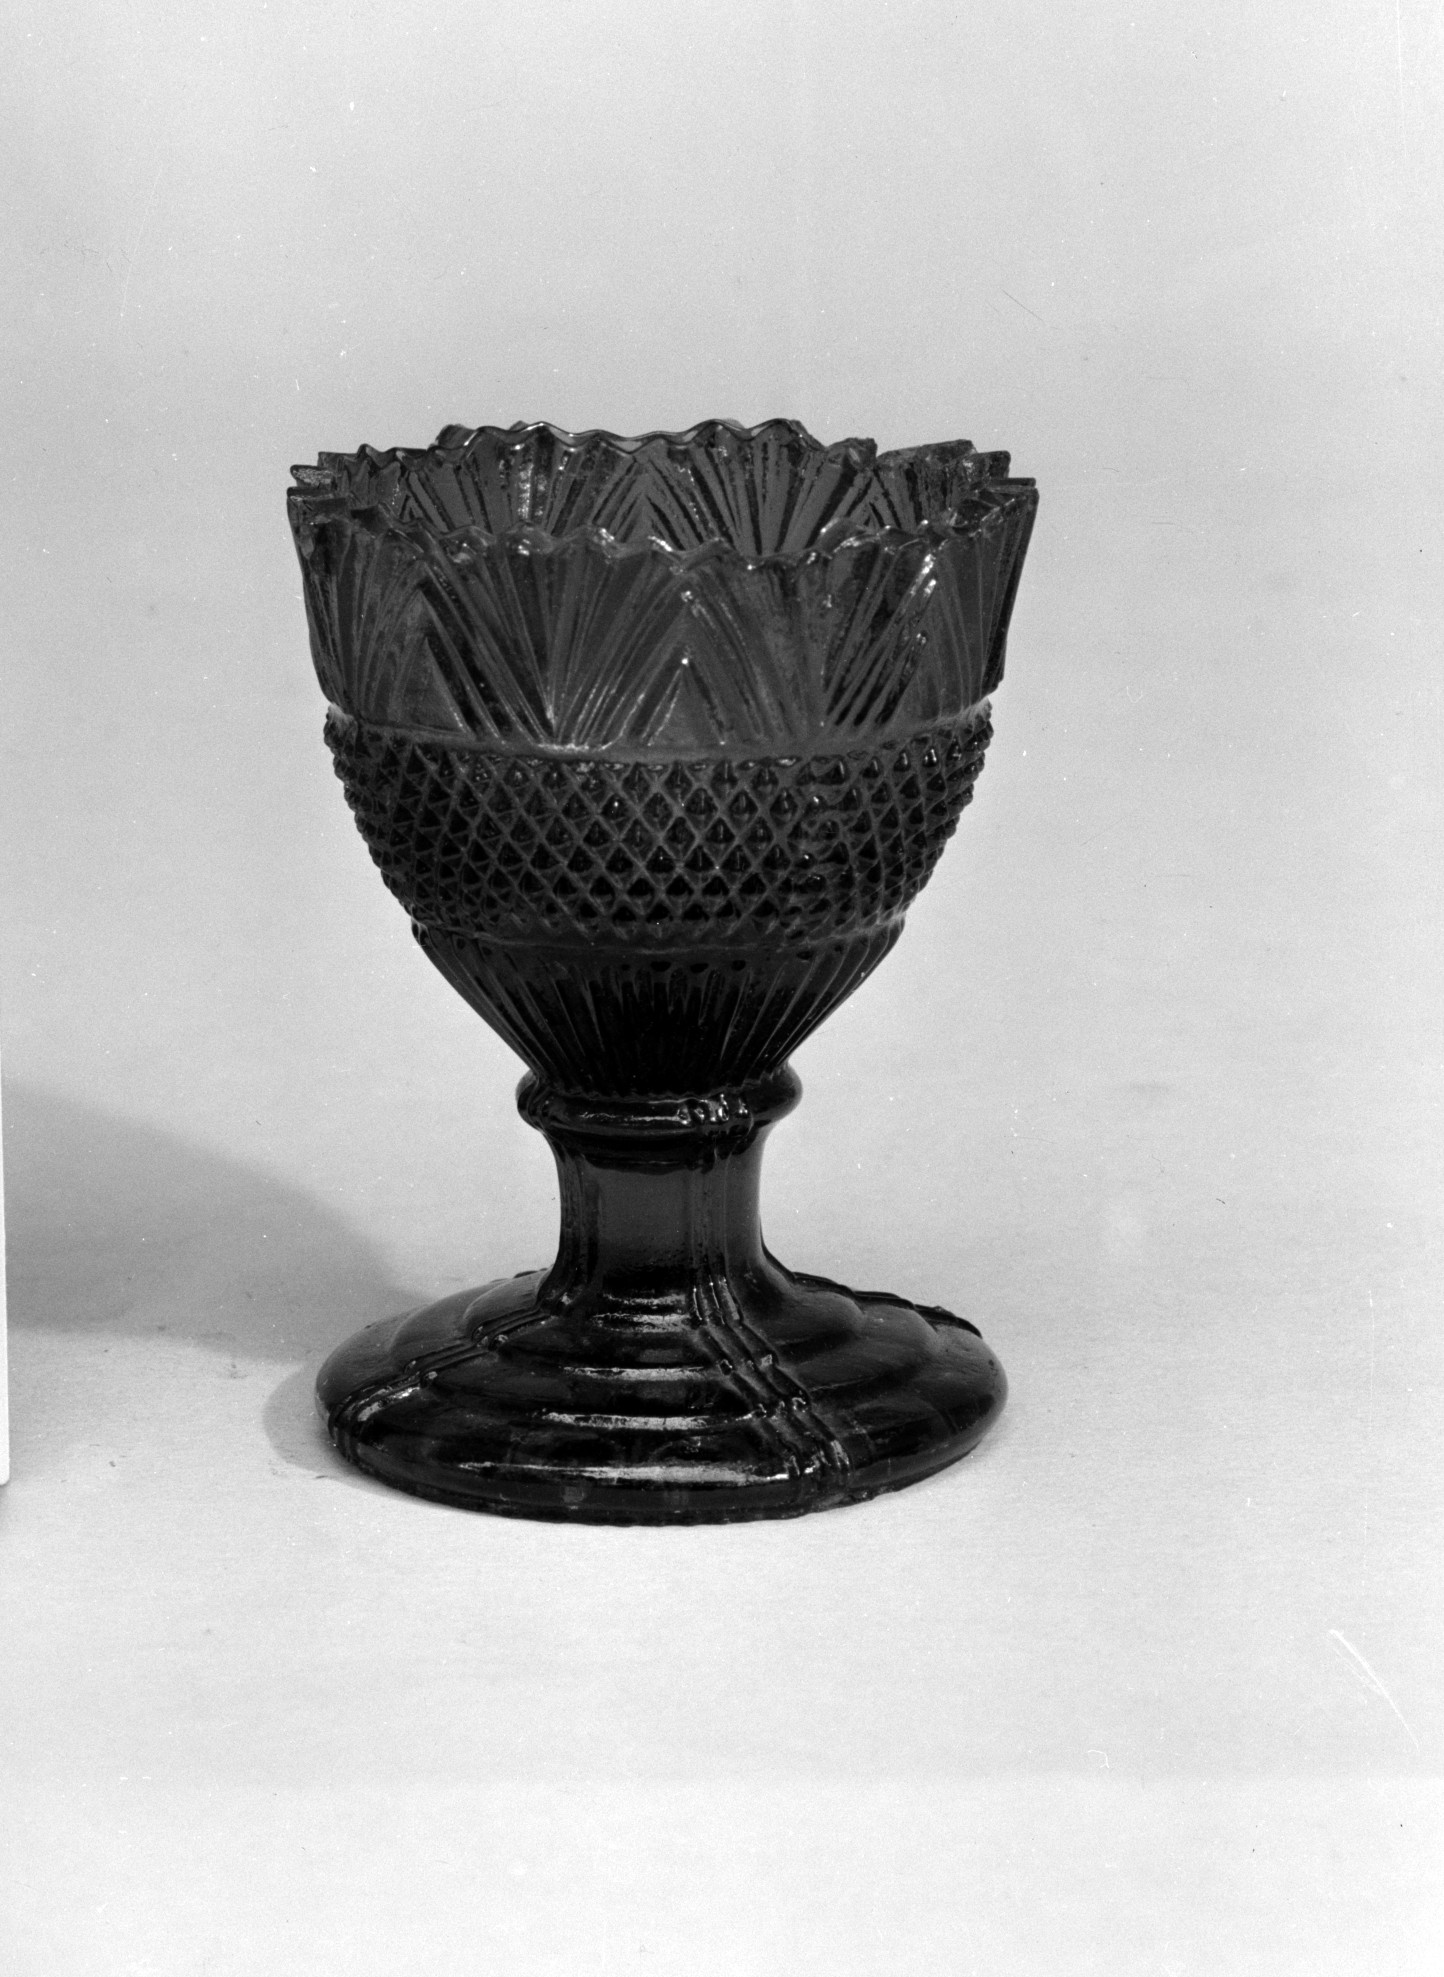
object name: egg cup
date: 1830-1900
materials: glass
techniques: pressed